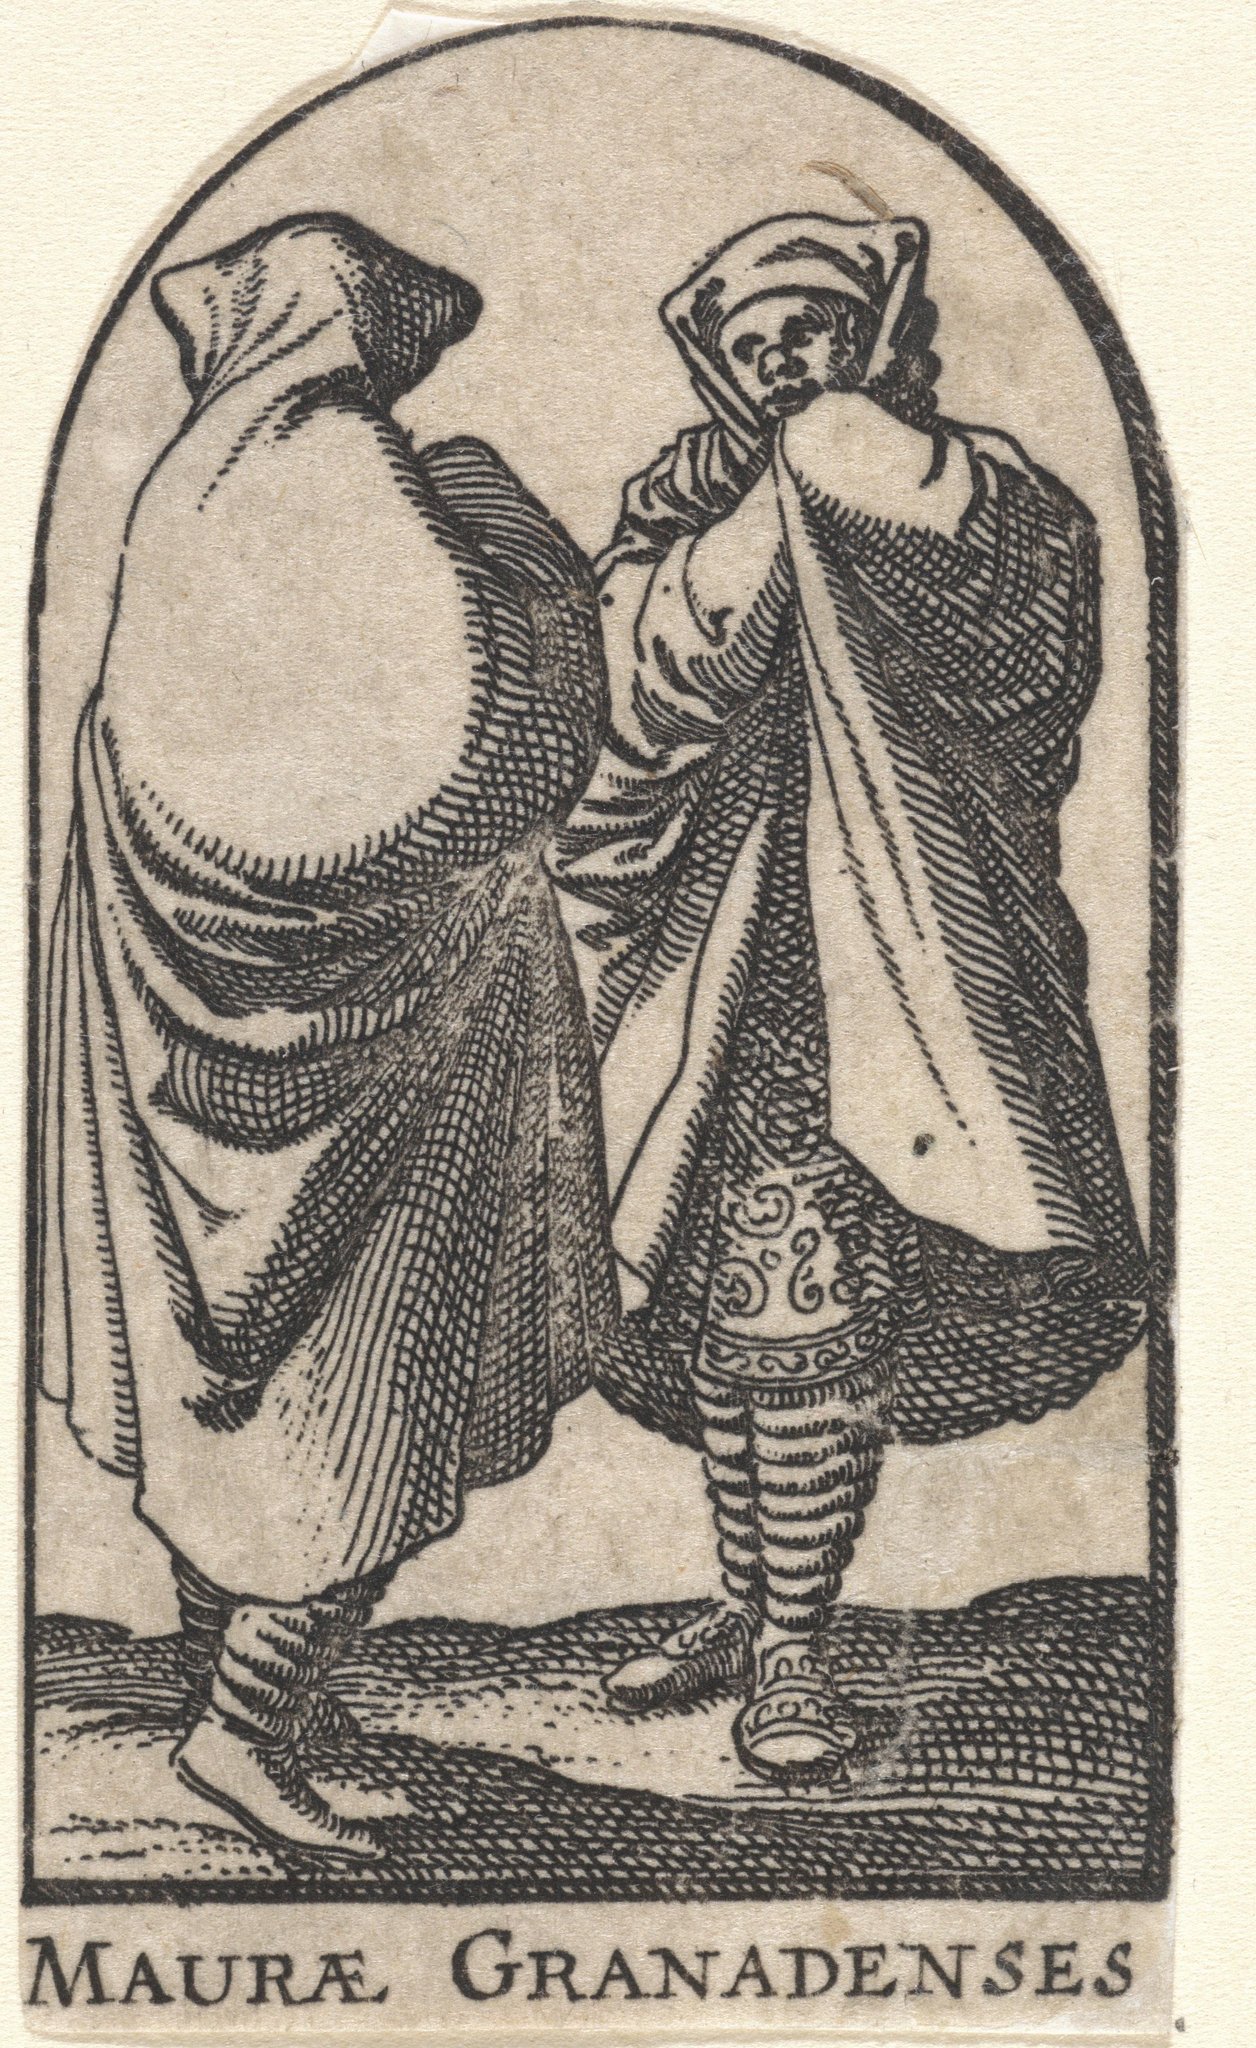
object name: costume print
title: Twee gesluierde vrouwen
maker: claes jansz. visscher (ii)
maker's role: draughtsman, print maker, publisher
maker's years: 1586-1652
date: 1596-1630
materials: paper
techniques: etching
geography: amsterdam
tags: veil